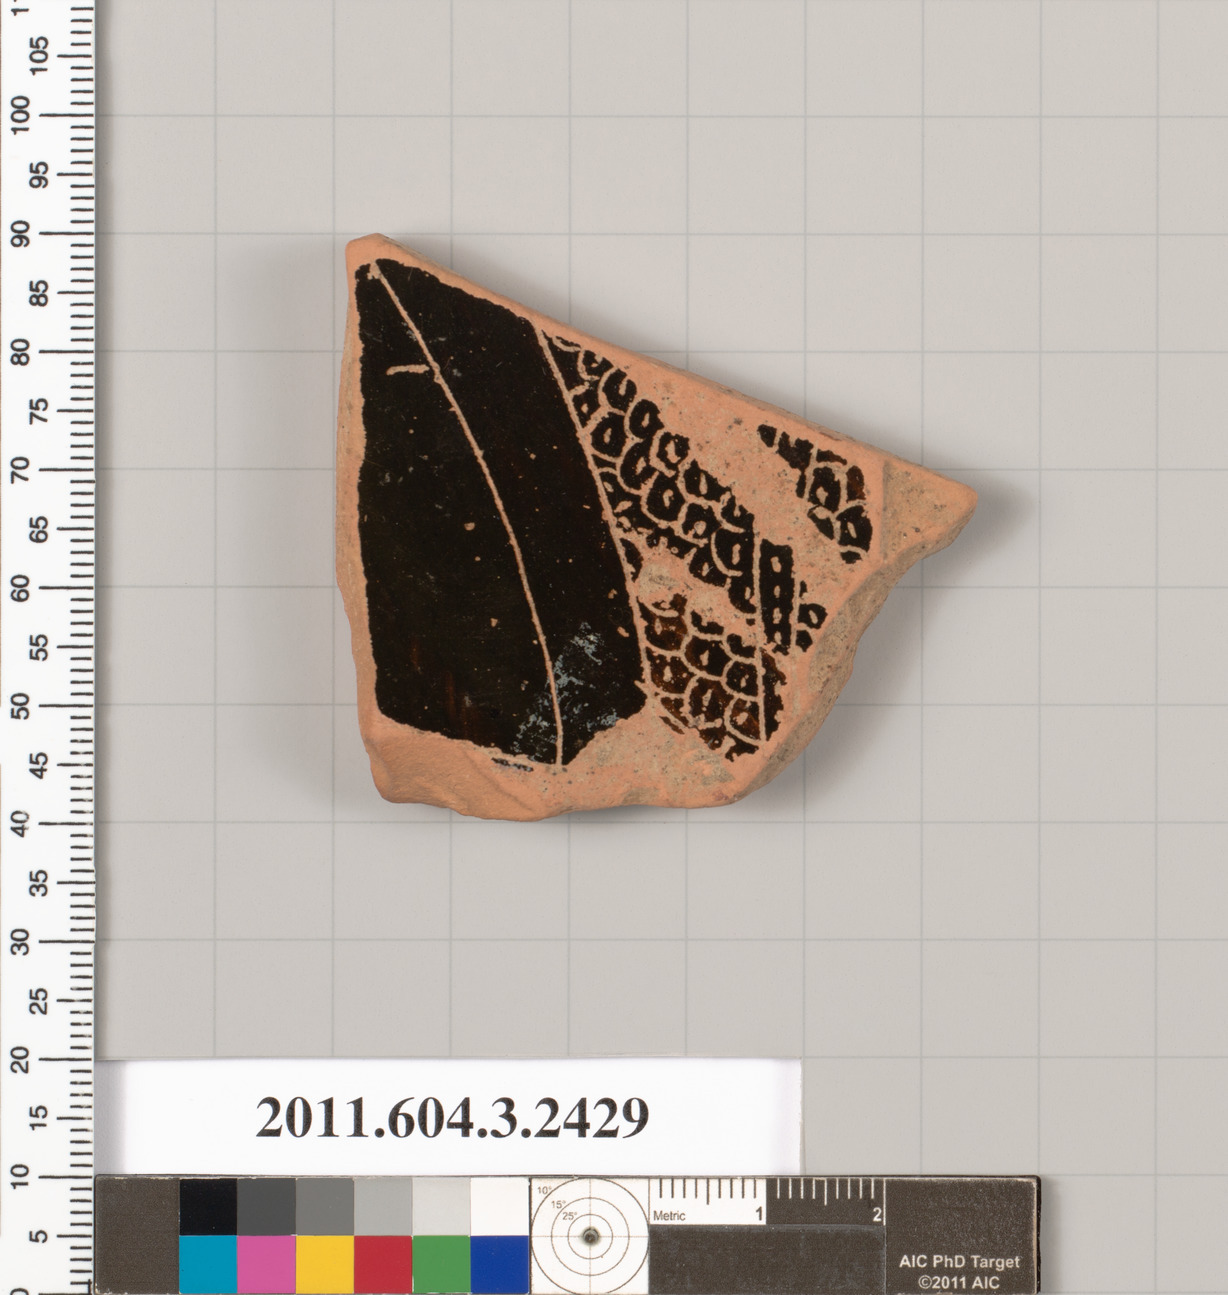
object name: kylix fragment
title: Terracotta fragment of a kylix (drinking cup)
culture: greek, attic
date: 525-501 BCE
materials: terracotta